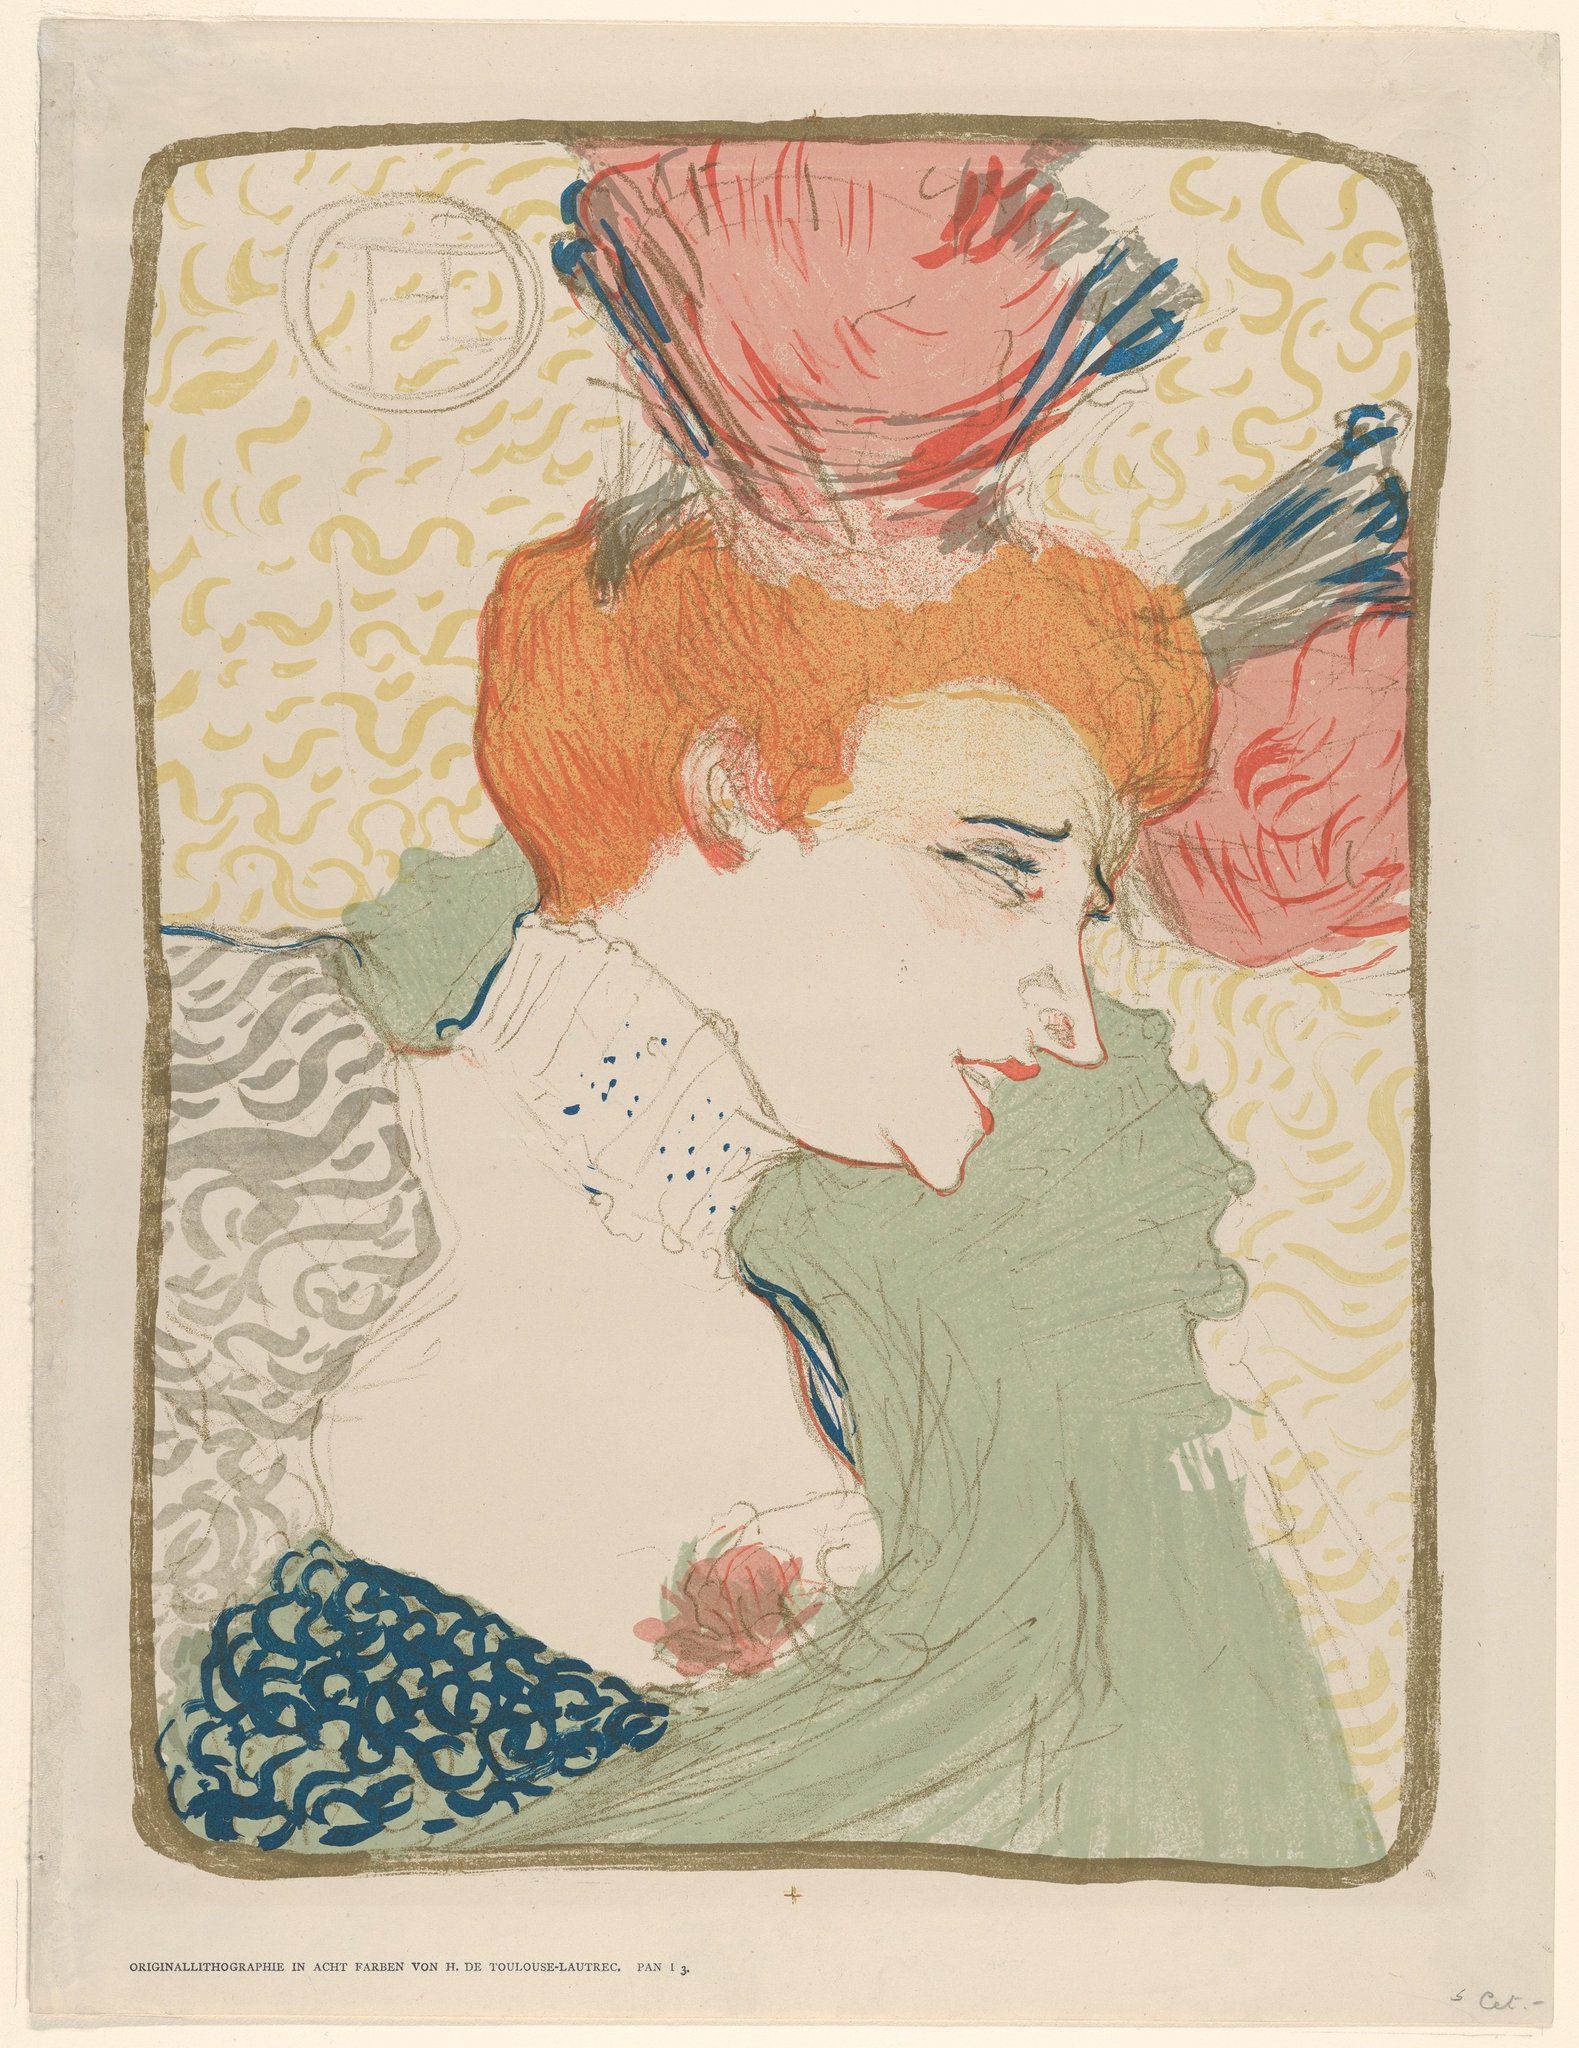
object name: print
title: Portrait Bust of Mademoiselle Marcelle Lender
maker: henri de toulouse-lautrec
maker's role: artist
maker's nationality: french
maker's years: 1864-1901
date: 1895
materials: crayon, paper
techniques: brush, letterpress, lithograph, printing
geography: france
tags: women